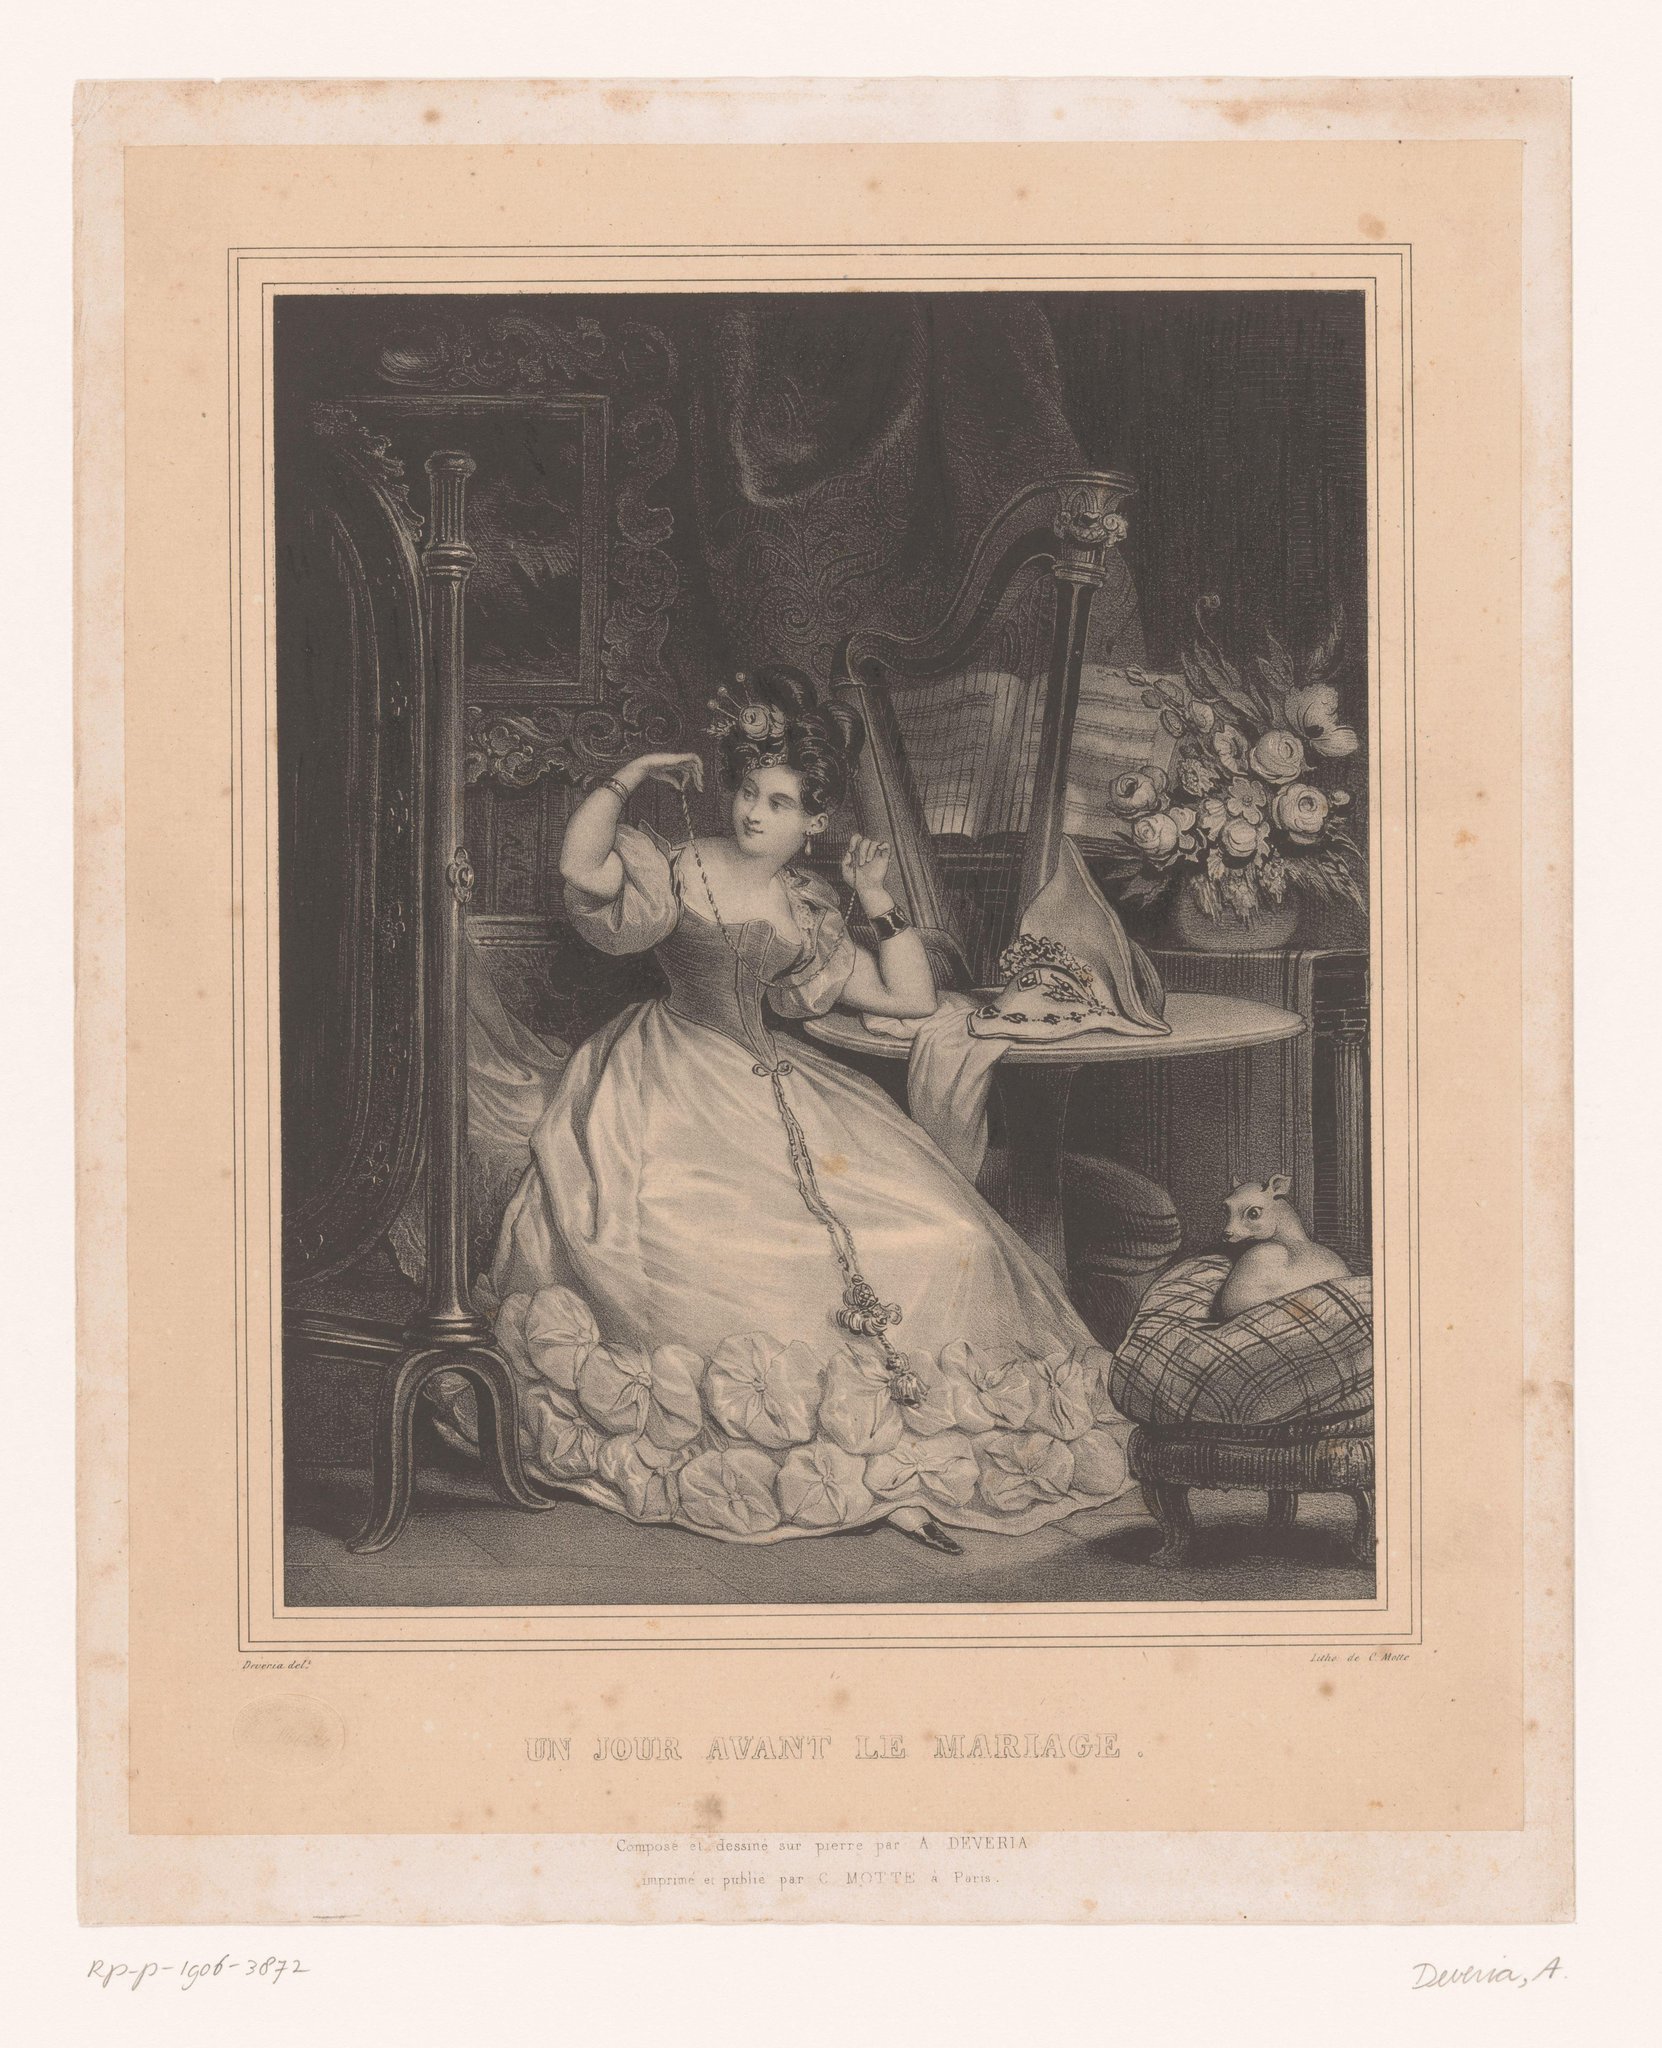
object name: print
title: Un jour avant le mariage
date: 1832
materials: paper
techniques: lithograph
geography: paris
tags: looking in the mirror; (possibly: contemplation of own beauty - aa - (for) women), dressing the bride, necklace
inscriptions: check stamp: Lugt 1828c, collector's mark: Lugt 2228a